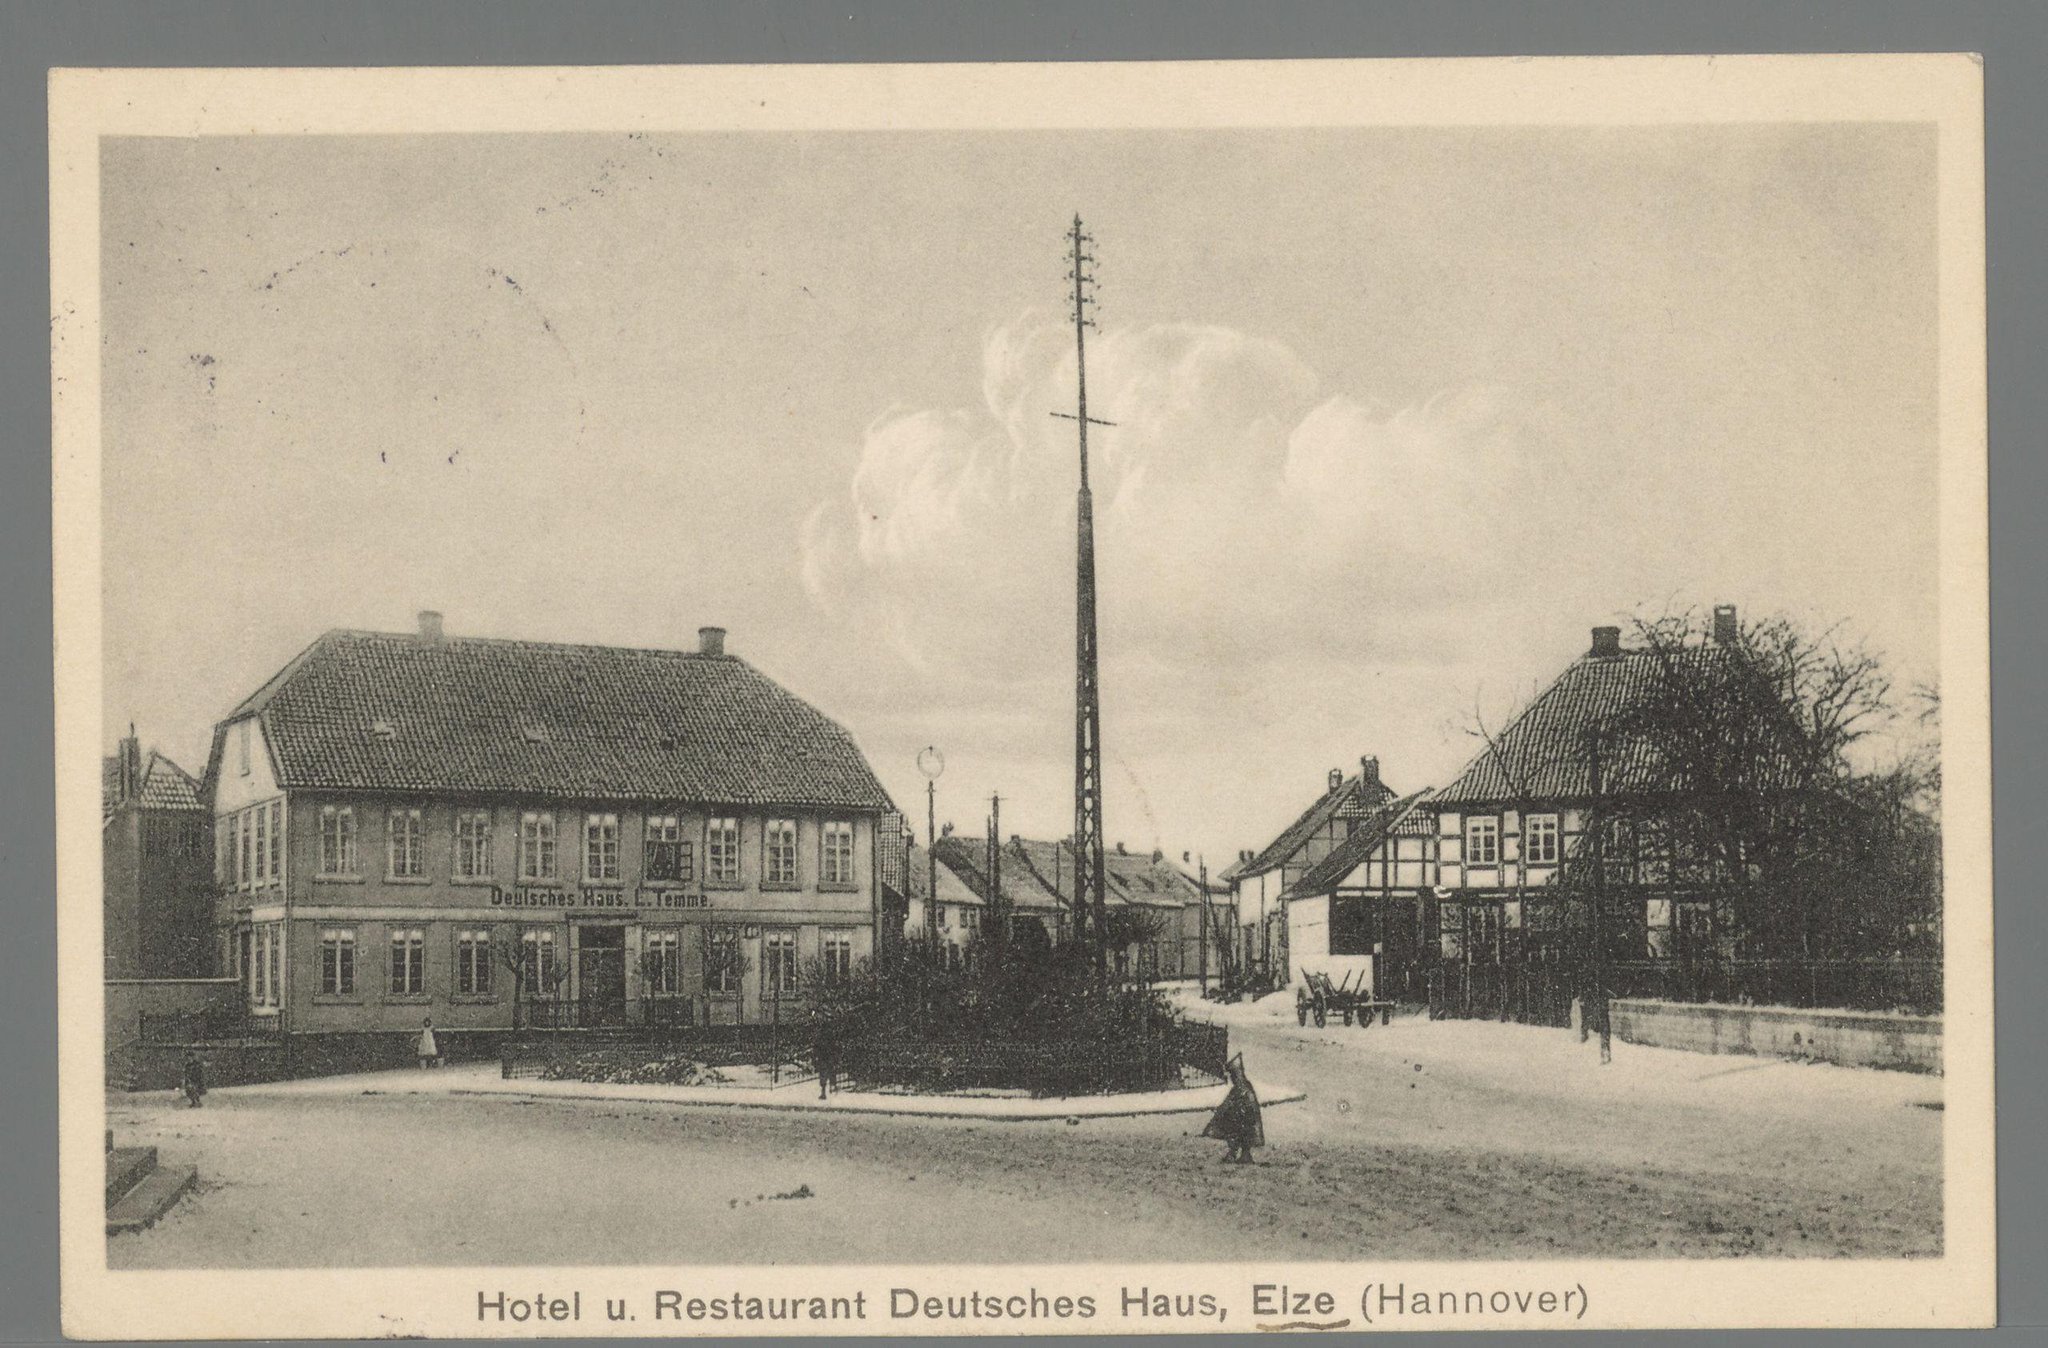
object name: ansichtkaart, prentbriefkaart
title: Hotel u. Restaurant Deutsches Haus, Elze (Hannover)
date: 1905-1913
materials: cardboard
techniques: photograph, writing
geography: elze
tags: restaurant, hotel, hostelry, inn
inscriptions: postage stamp